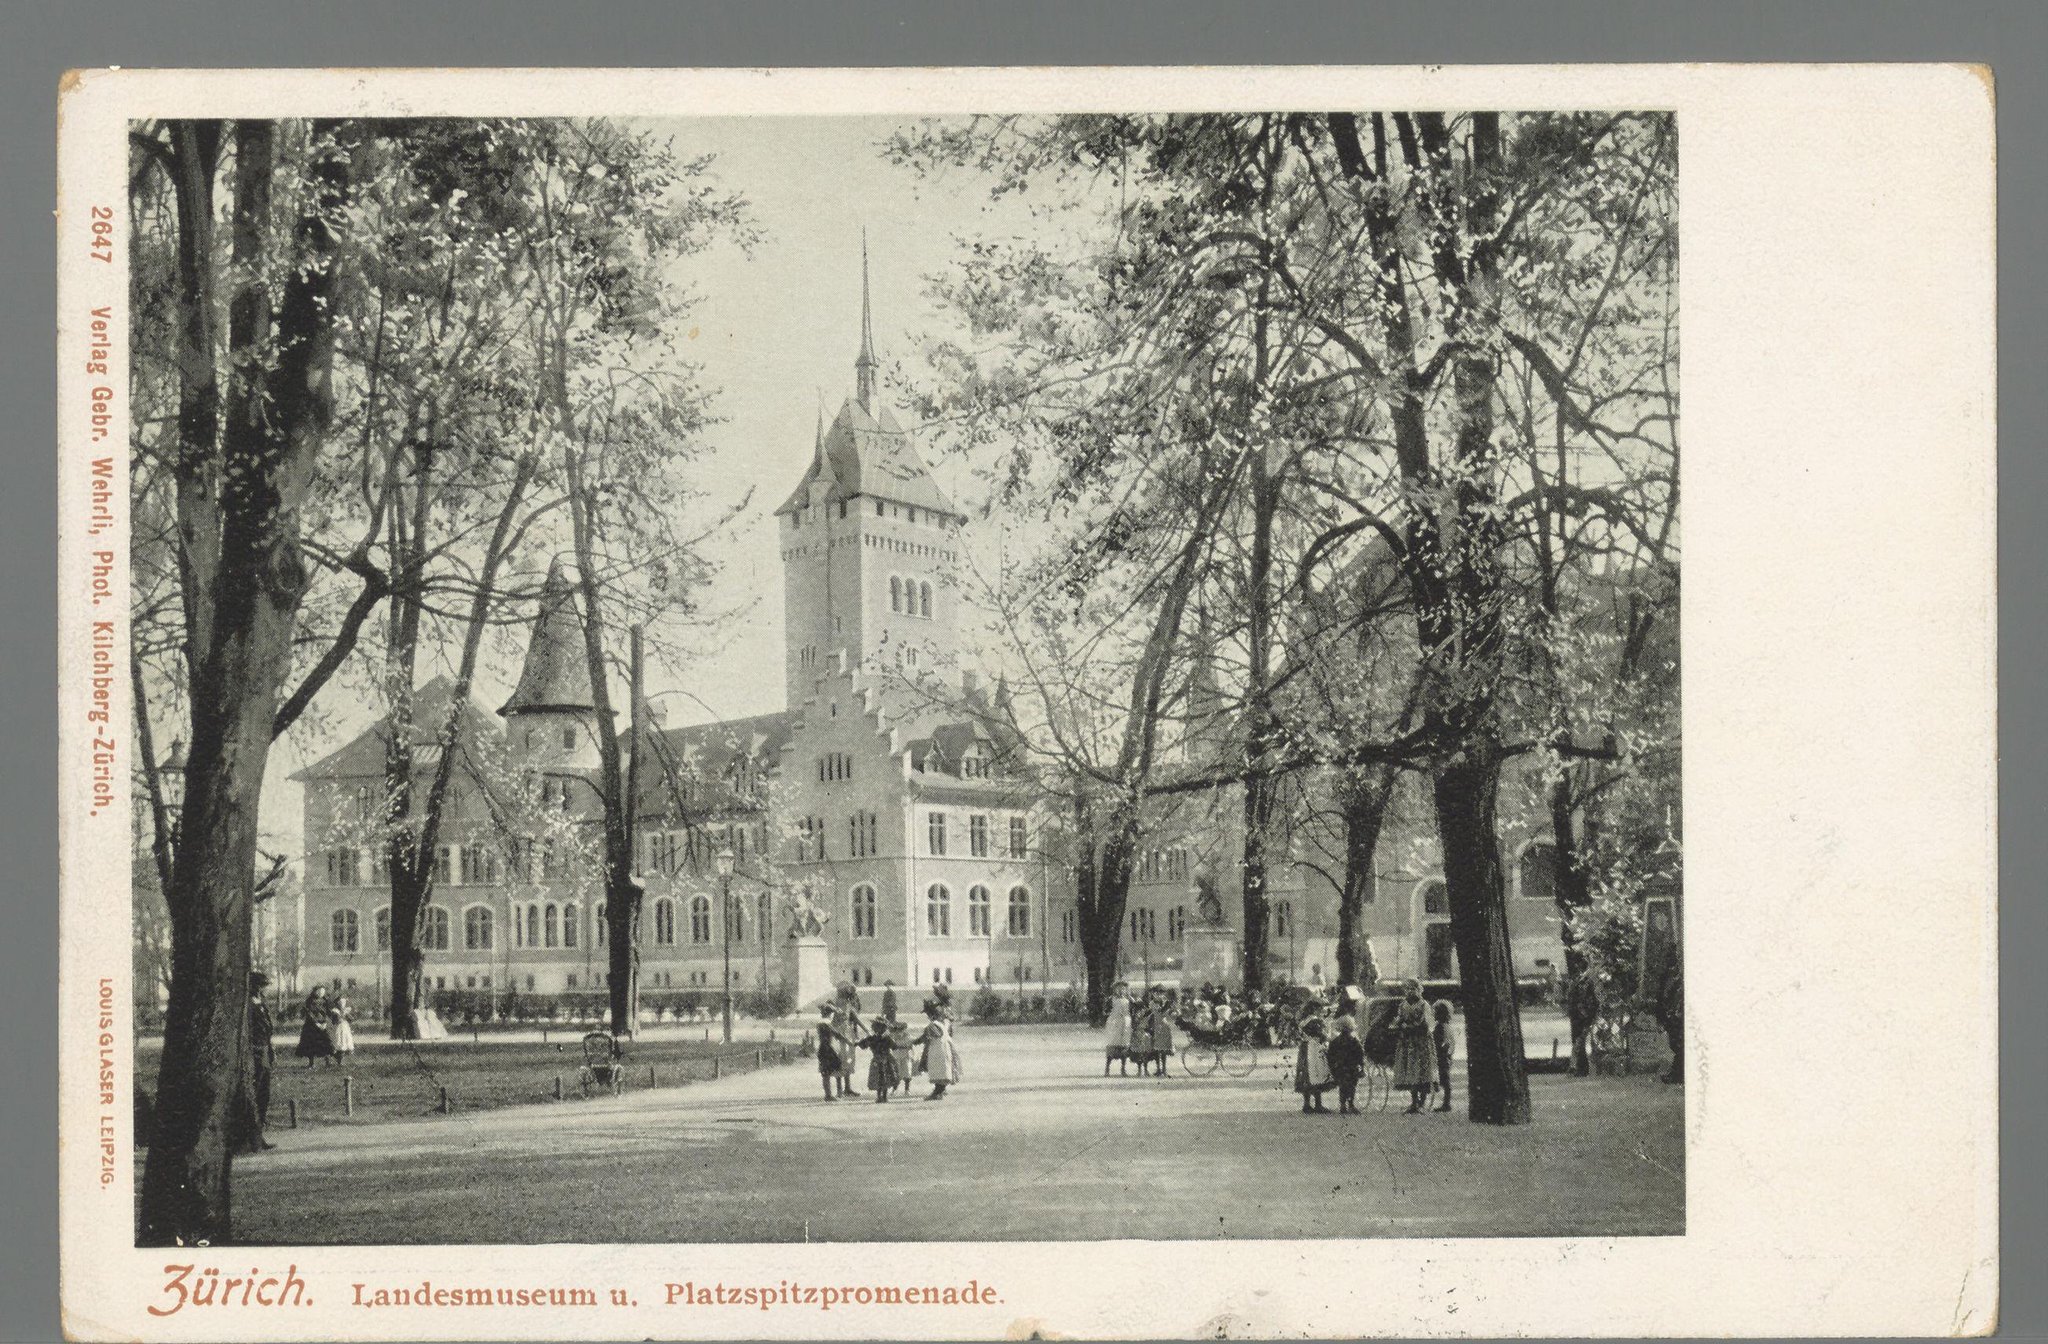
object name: ansichtkaart, prentbriefkaart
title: Zürich. Landesmuseum u. Platzspitzpromenade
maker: louis glaser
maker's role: printer, publisher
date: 1897-1902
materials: cardboard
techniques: writing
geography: leipzig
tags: public gardens, park (+ city(-scape) with figures, staffage), permanent exhibition, museum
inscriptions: postage stamp